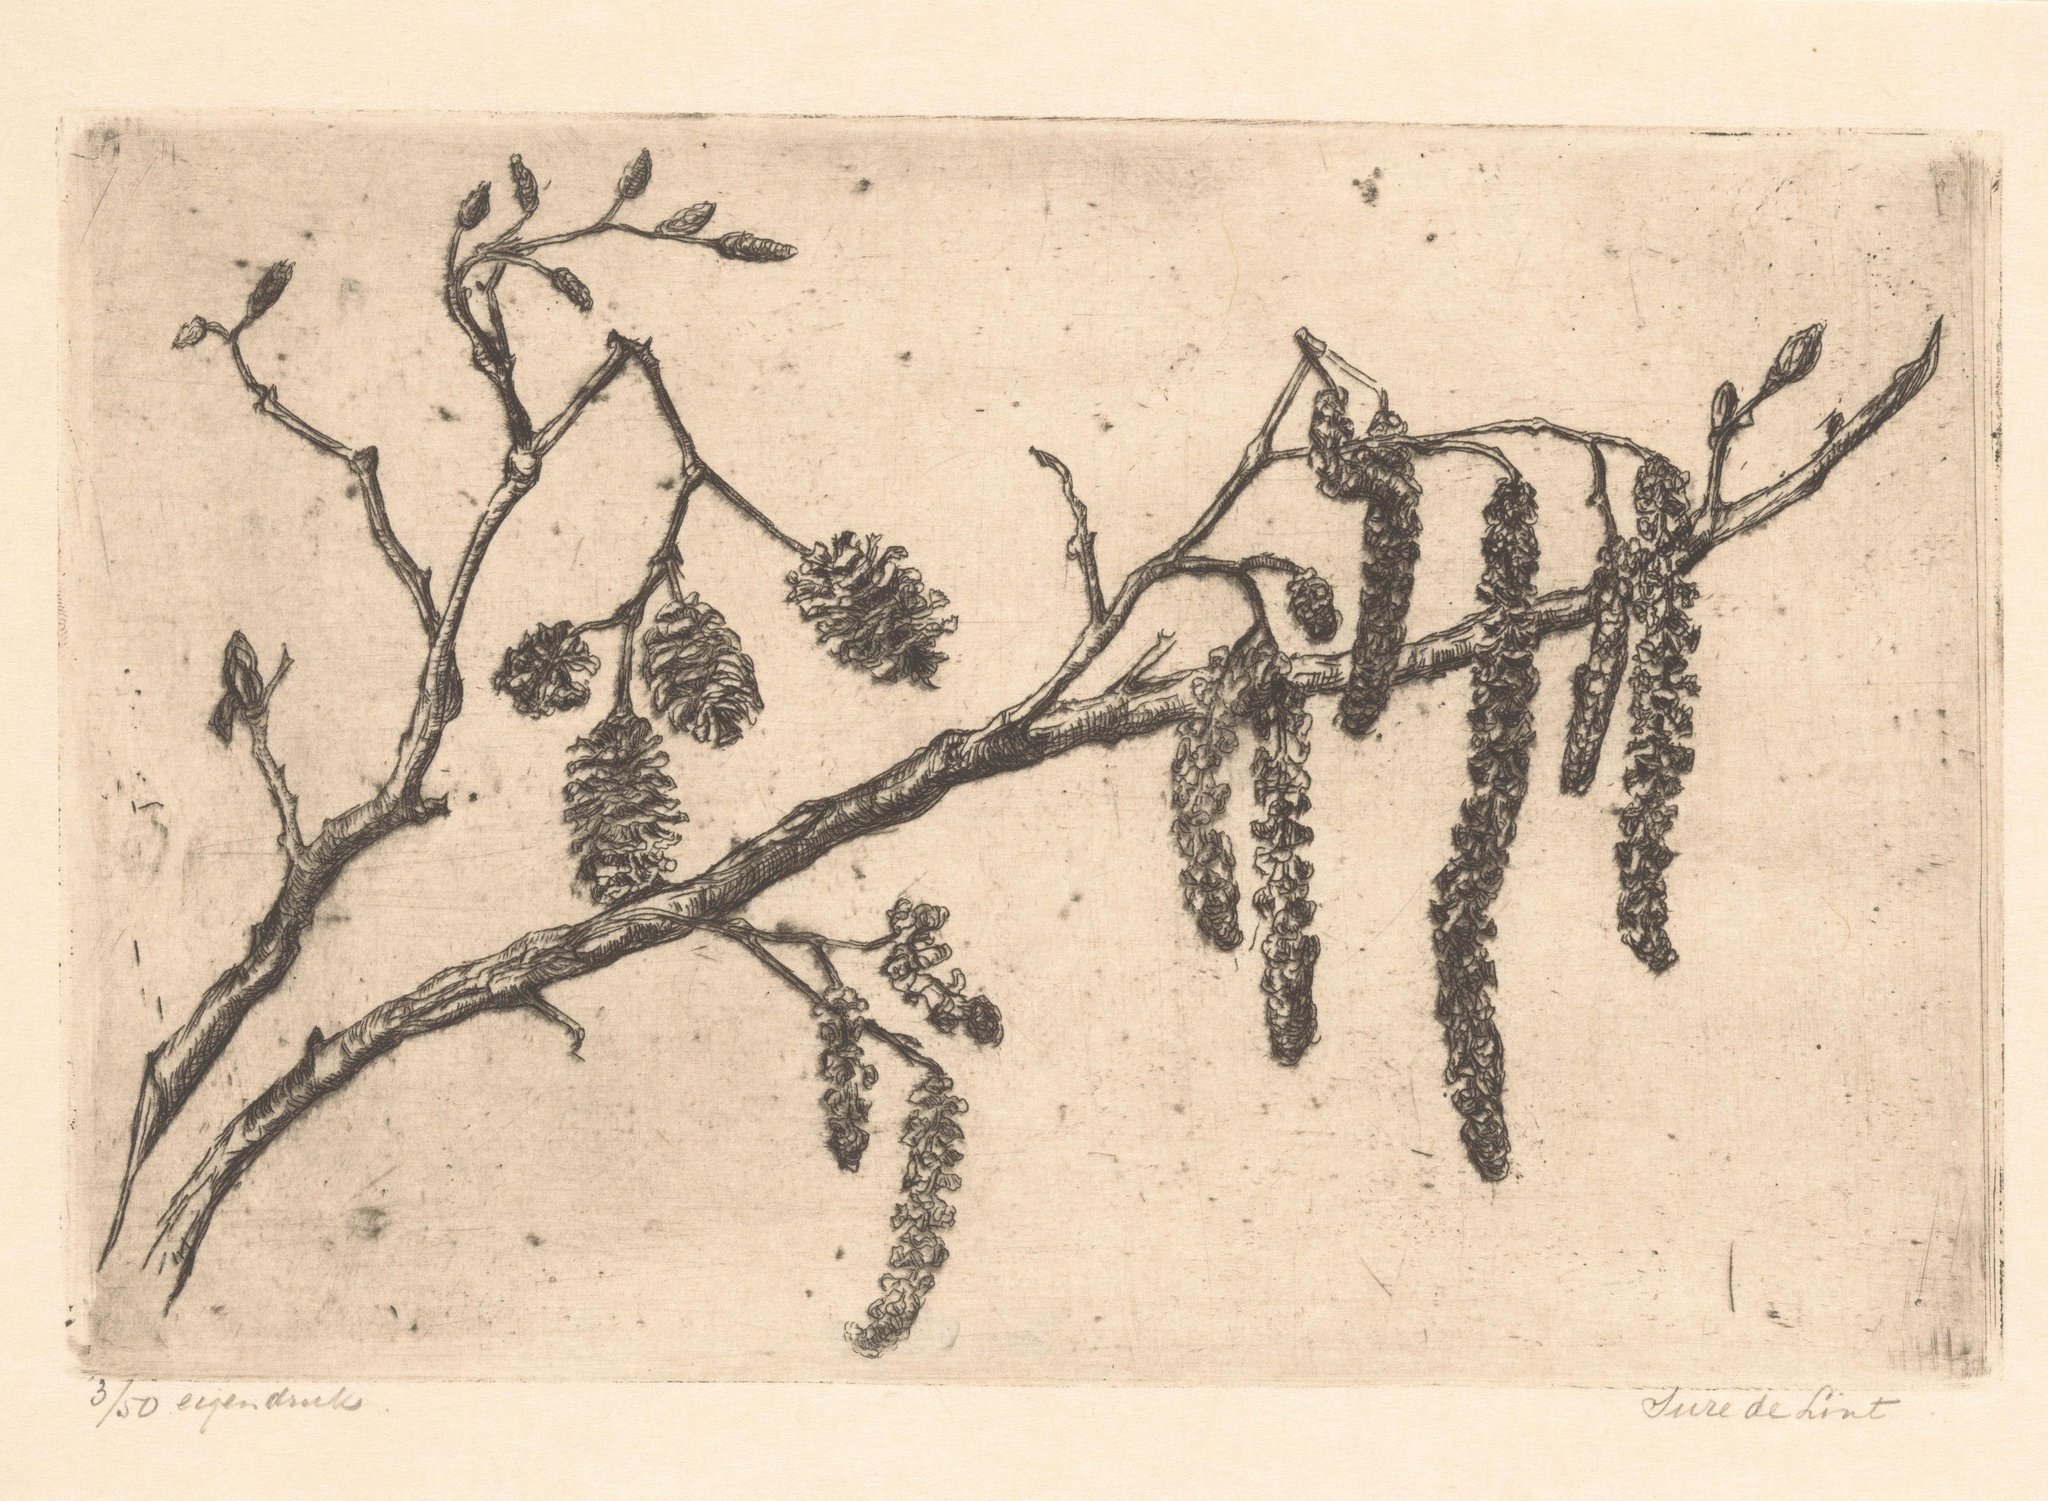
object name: print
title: Elzenkatjes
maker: suze de lint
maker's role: print maker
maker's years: 1878-1953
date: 1888-1931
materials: paper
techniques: etching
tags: trees: alder